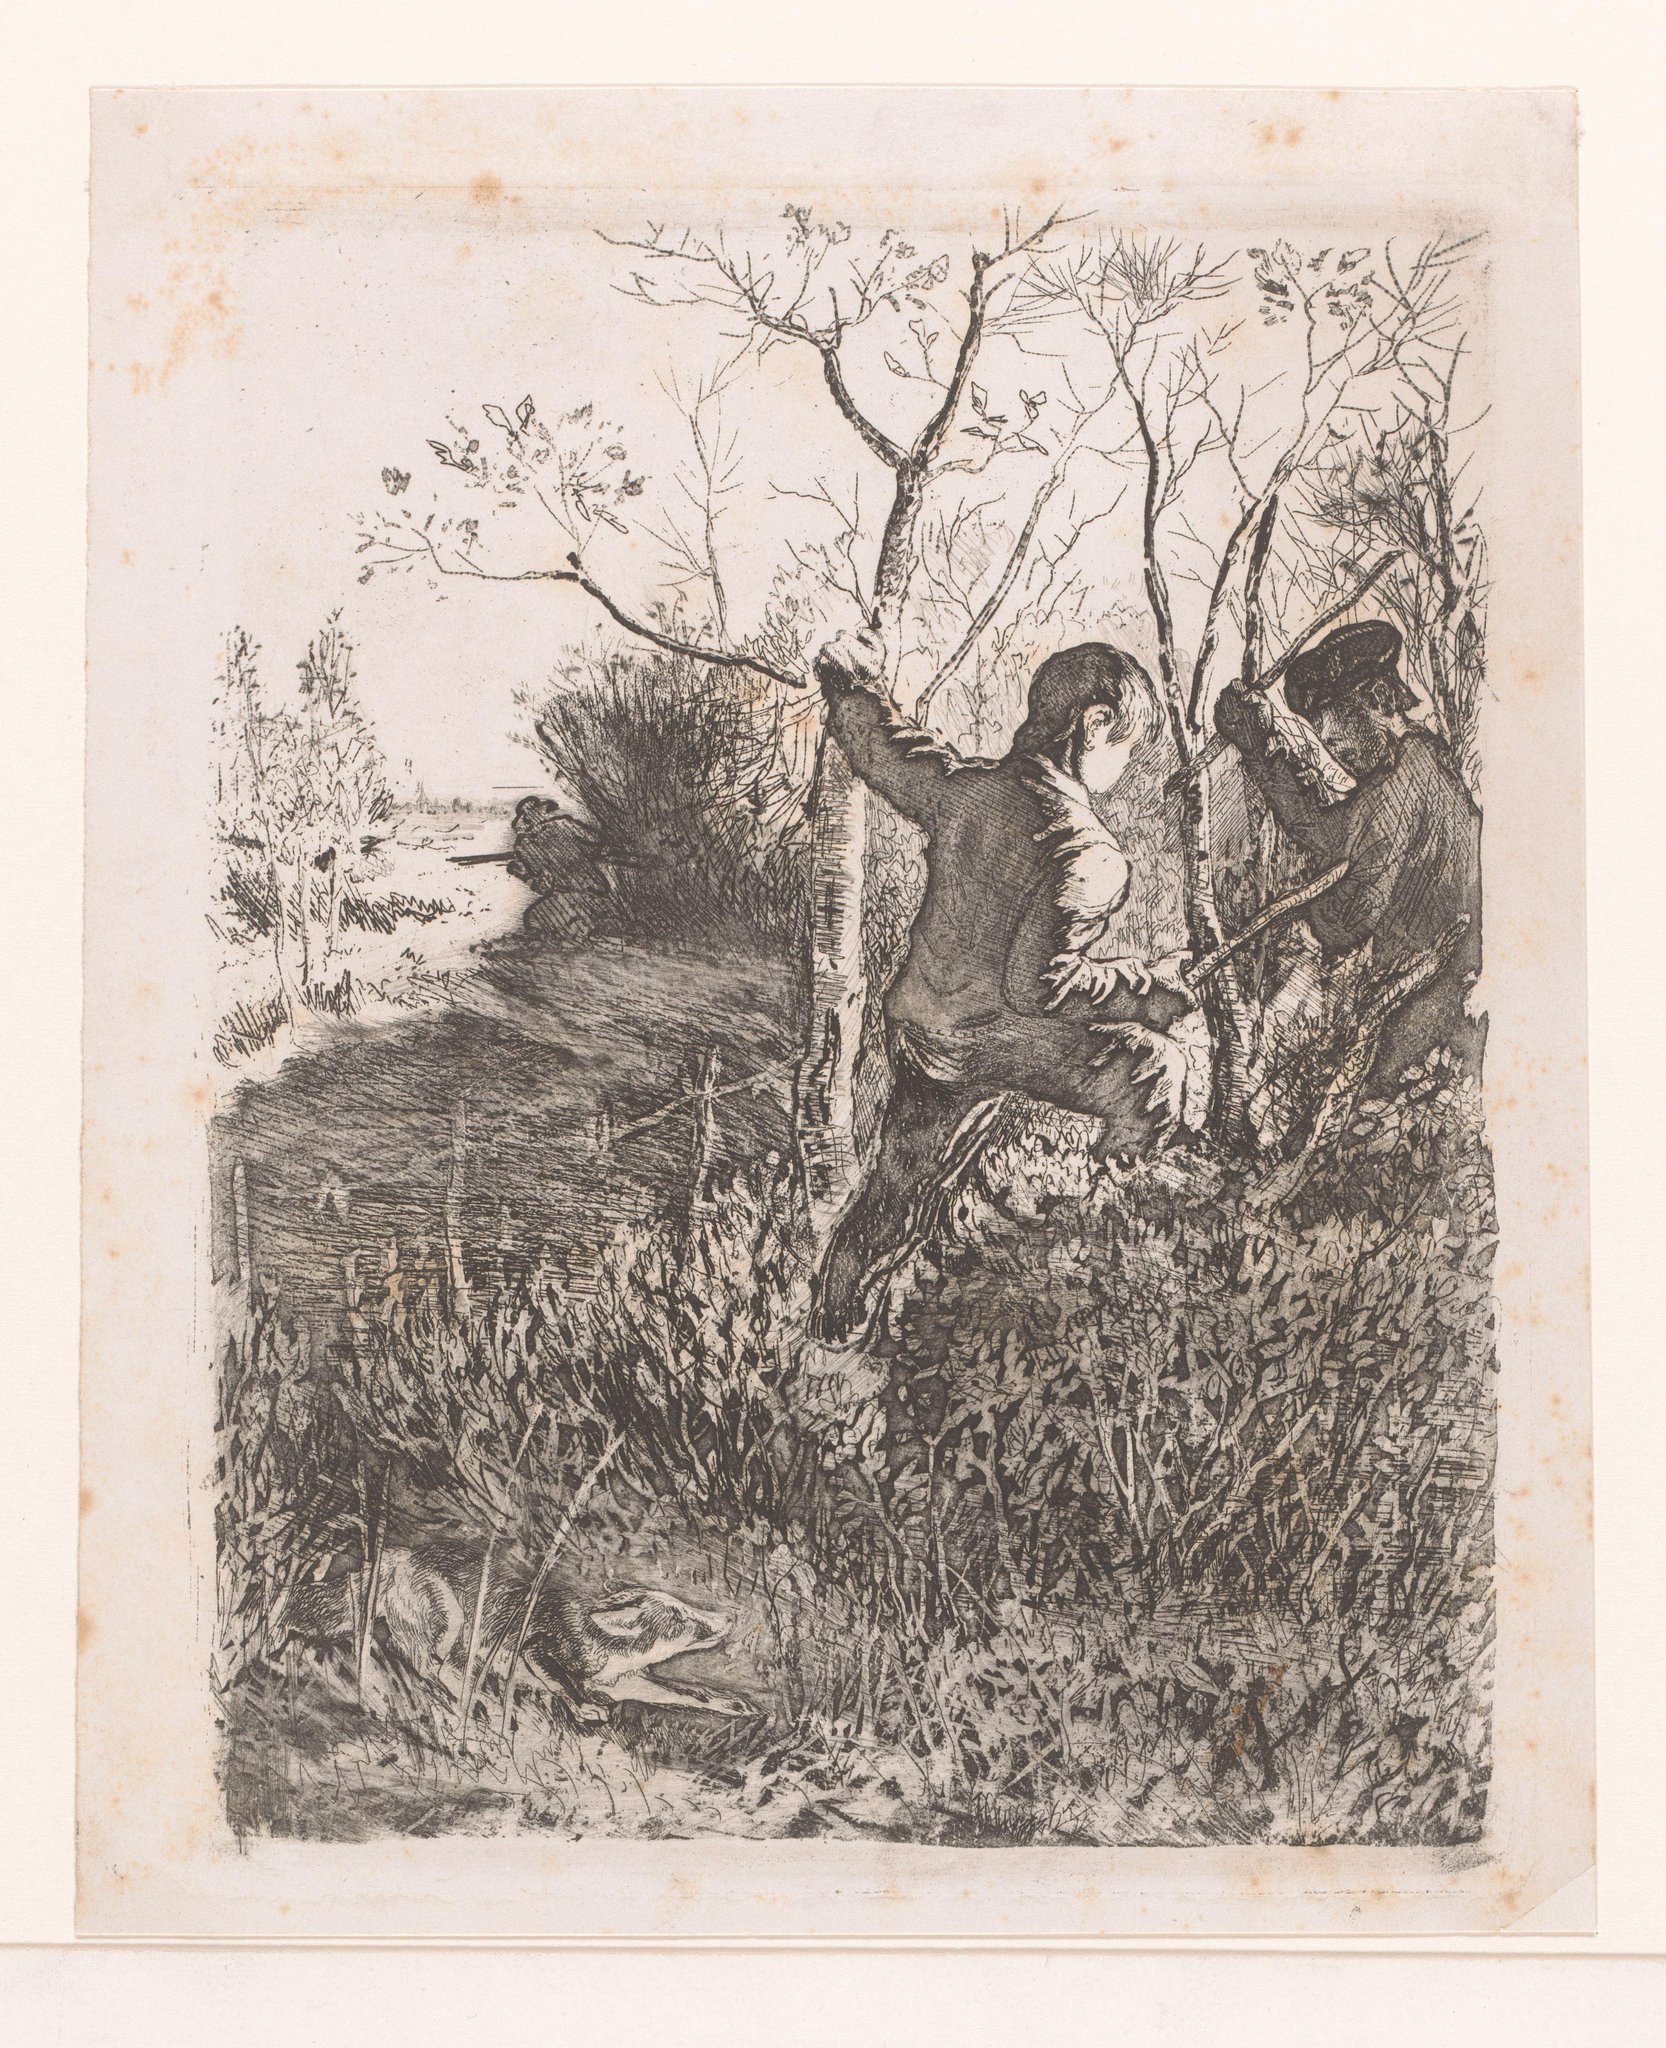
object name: print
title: Landschap met jager en twee vechtende jongens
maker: charles verlat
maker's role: painter, print maker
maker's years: 1824-1890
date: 1834-1890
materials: paper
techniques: aquatint, drypoint, etching, retroussage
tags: landscapes, hunter, fighting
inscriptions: collector's mark: Lugt 2228